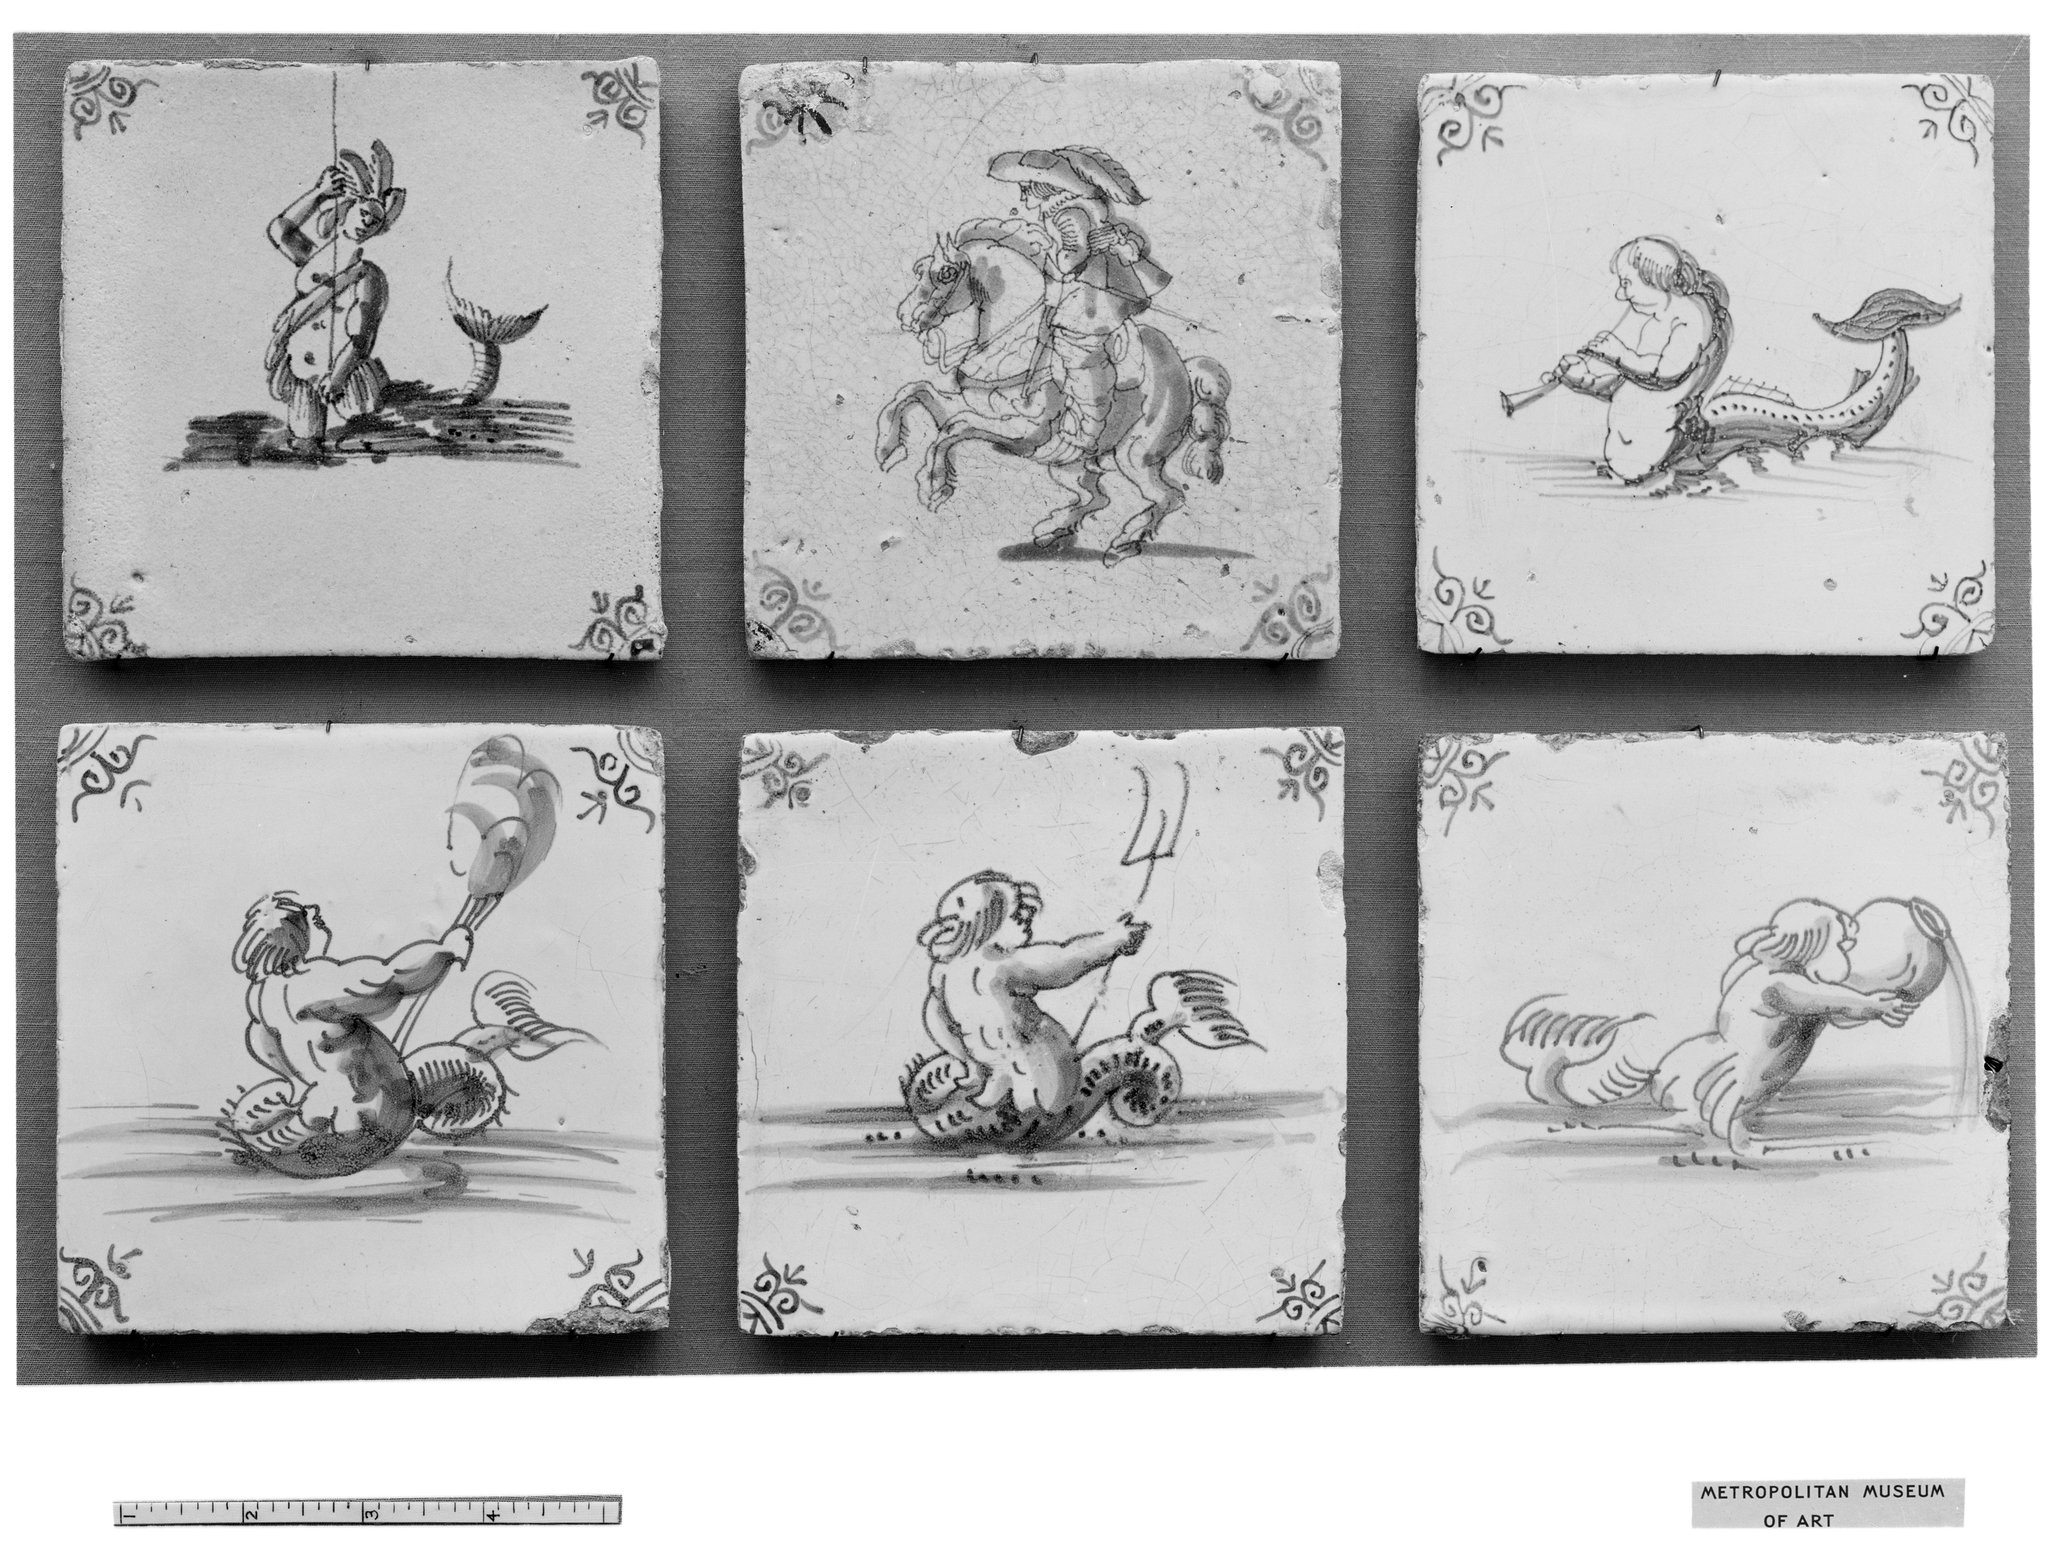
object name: tile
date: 1640-1660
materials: earthenware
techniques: glazing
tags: mermaids,horses